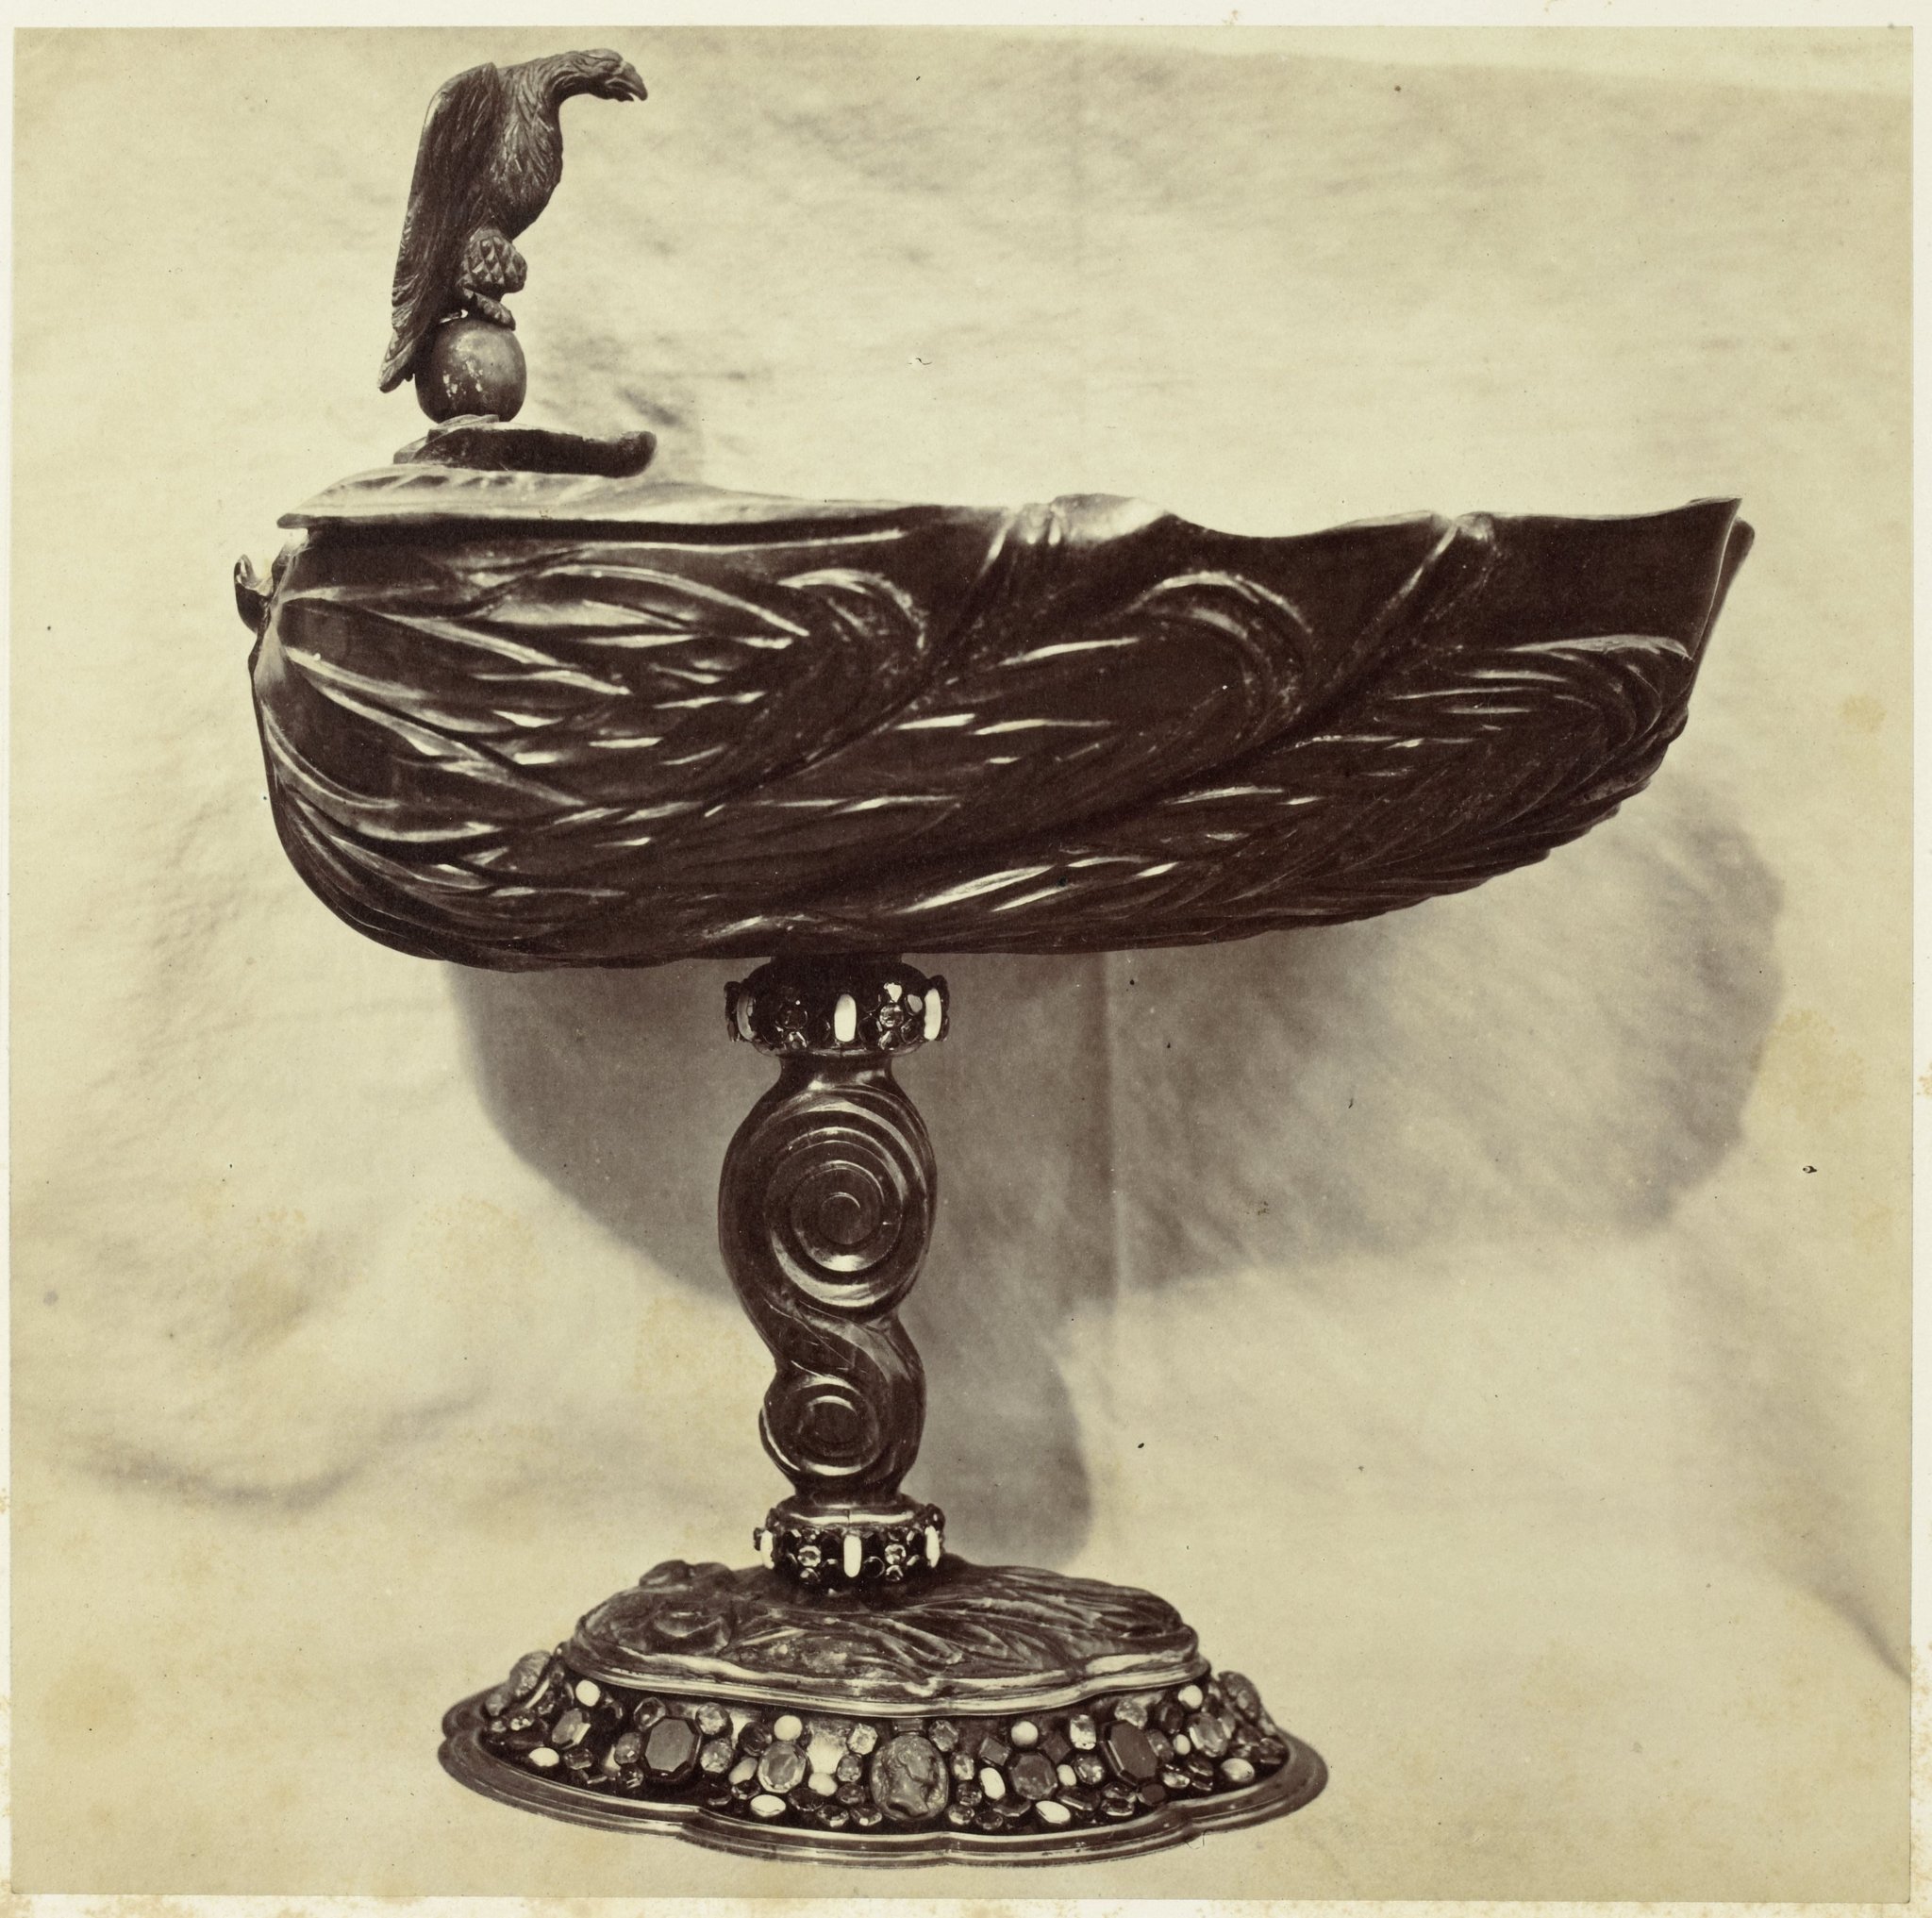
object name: photomechanical print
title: Metalen schaal met adelaar, uit het Louvre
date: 1866-1890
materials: paper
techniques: woodburytype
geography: louvre museum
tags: container of metal: bucket, can, canister, drum, tin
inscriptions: inscription: ‘Photographed by C. Thurston Thompson.’